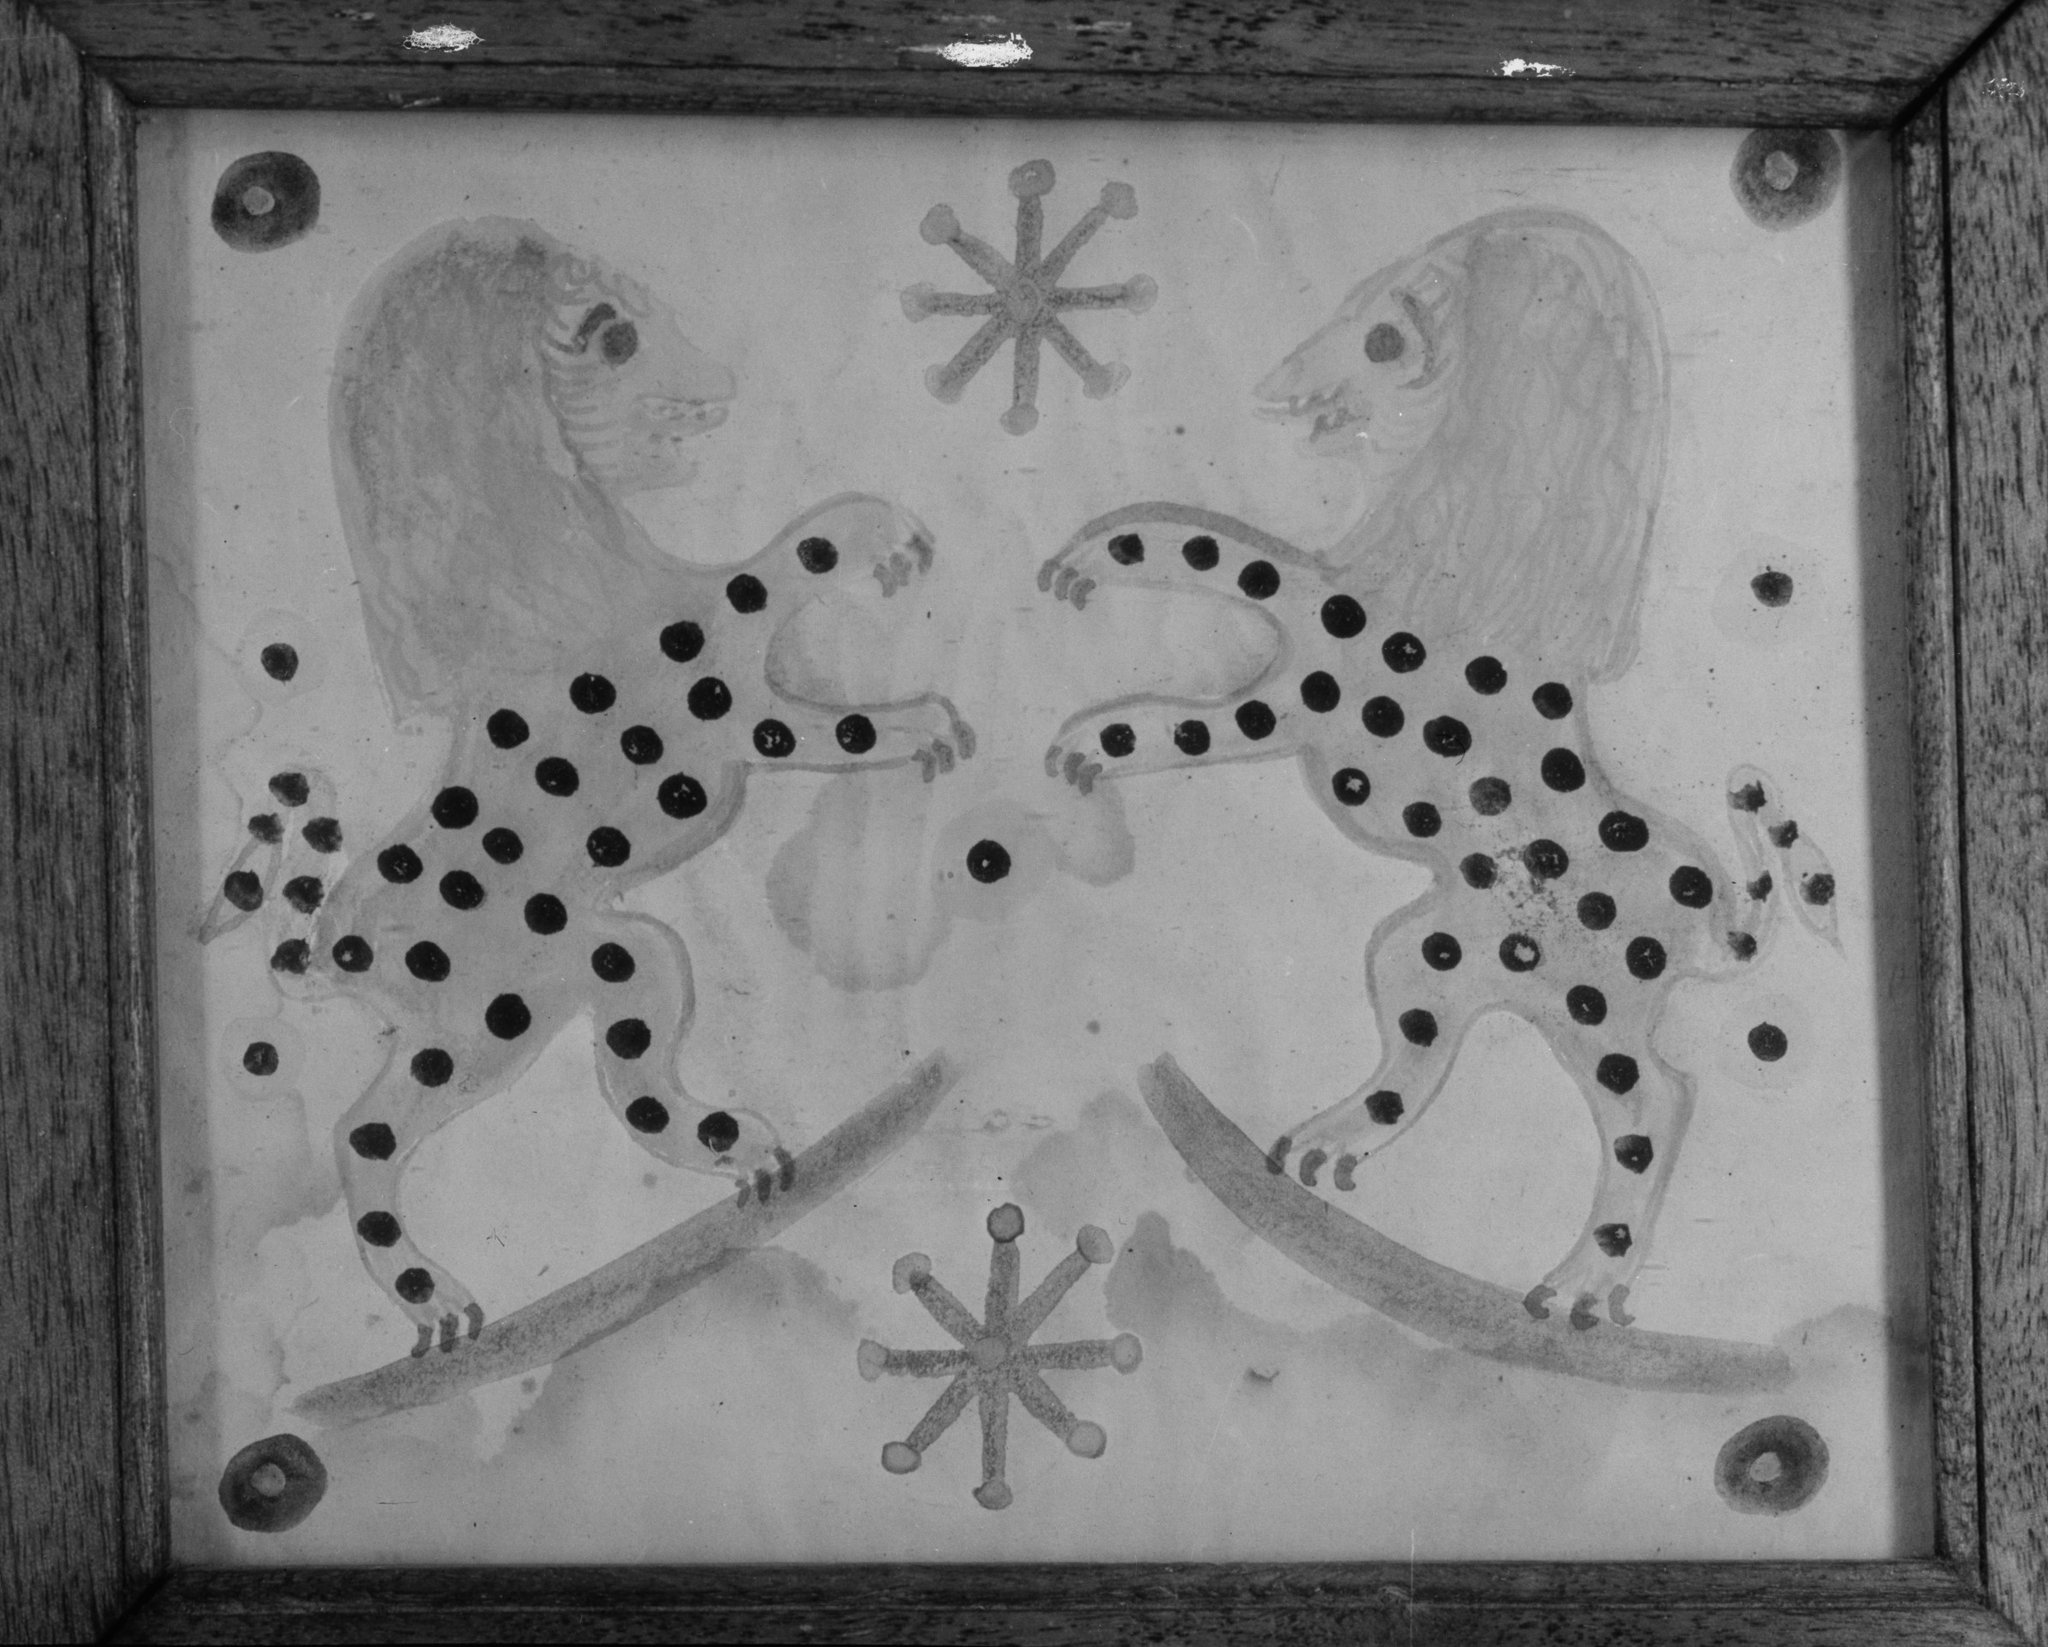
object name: drawing, fraktur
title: Drawing of Lions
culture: american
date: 1770-1800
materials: paper, watercolor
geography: united states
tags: lions